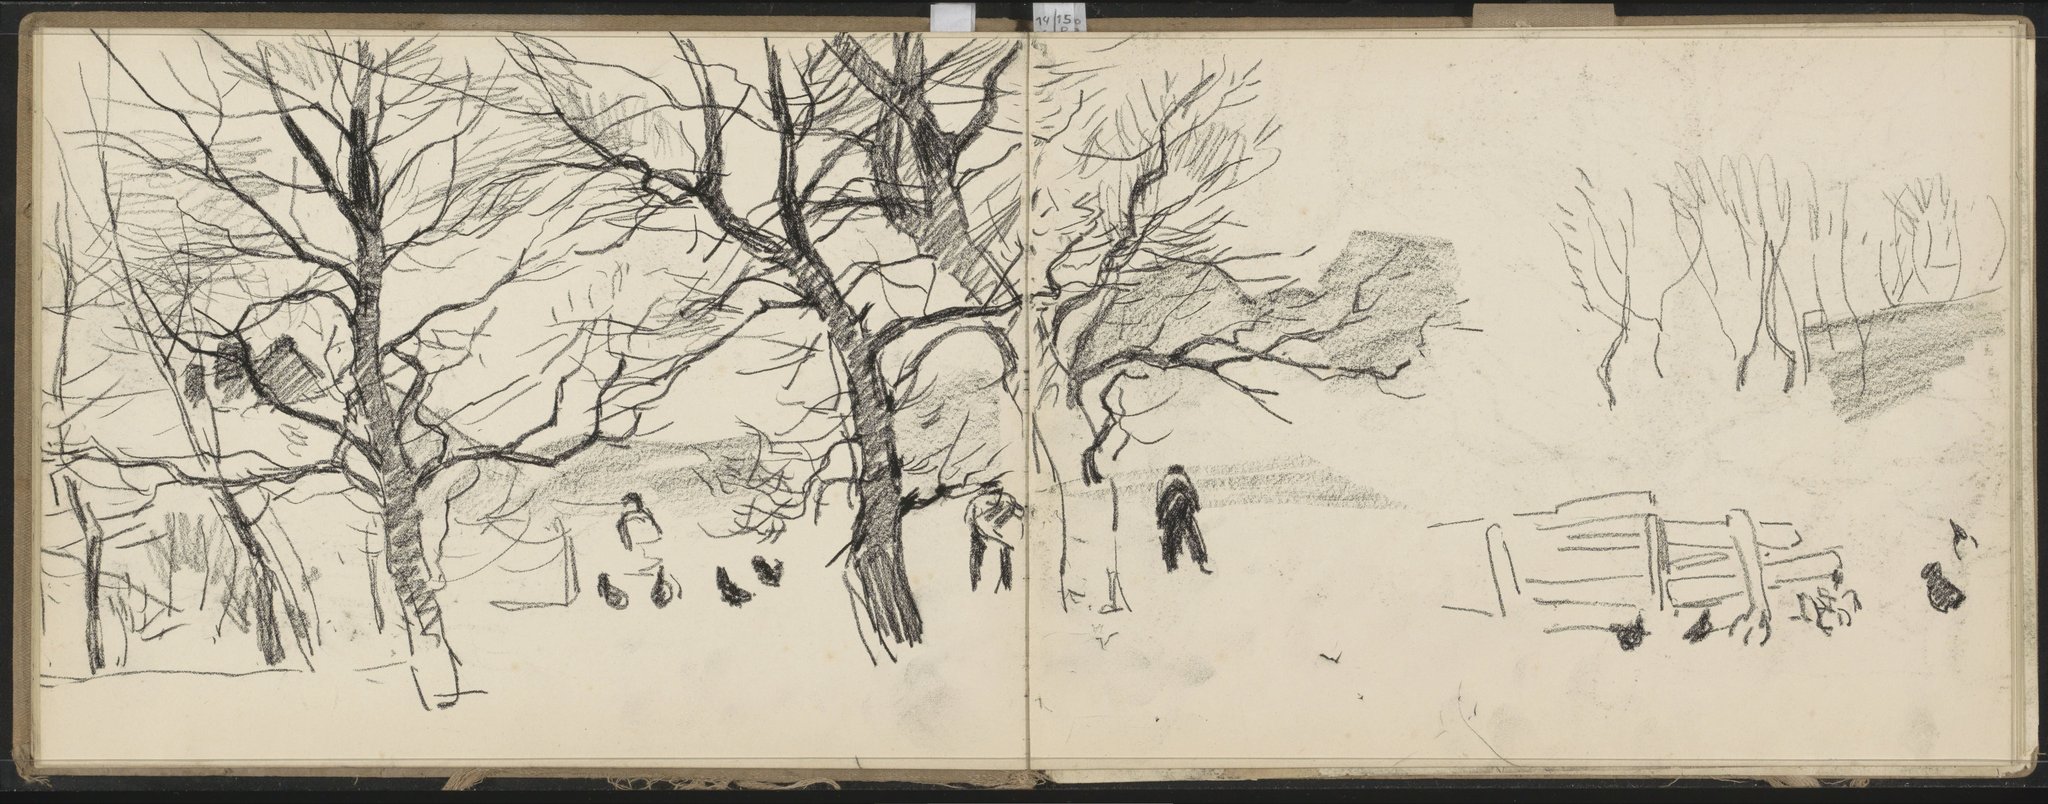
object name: sketchbook leaf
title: Figuren in een landschap met bomen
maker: willem bastiaan tholen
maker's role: draughtsman, painter, print maker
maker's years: 1860-1931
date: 1870-1931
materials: chalk, paper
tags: trees, fence, wall, paling, fowl (cock, hen, chicken, etc.), landscapes (+ landscape with figures, staffage)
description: Tevens studies van kippen bij een hek en kale bomen. Blad 11 verso en 12 recto uit een schetsboek met 22 bladen.